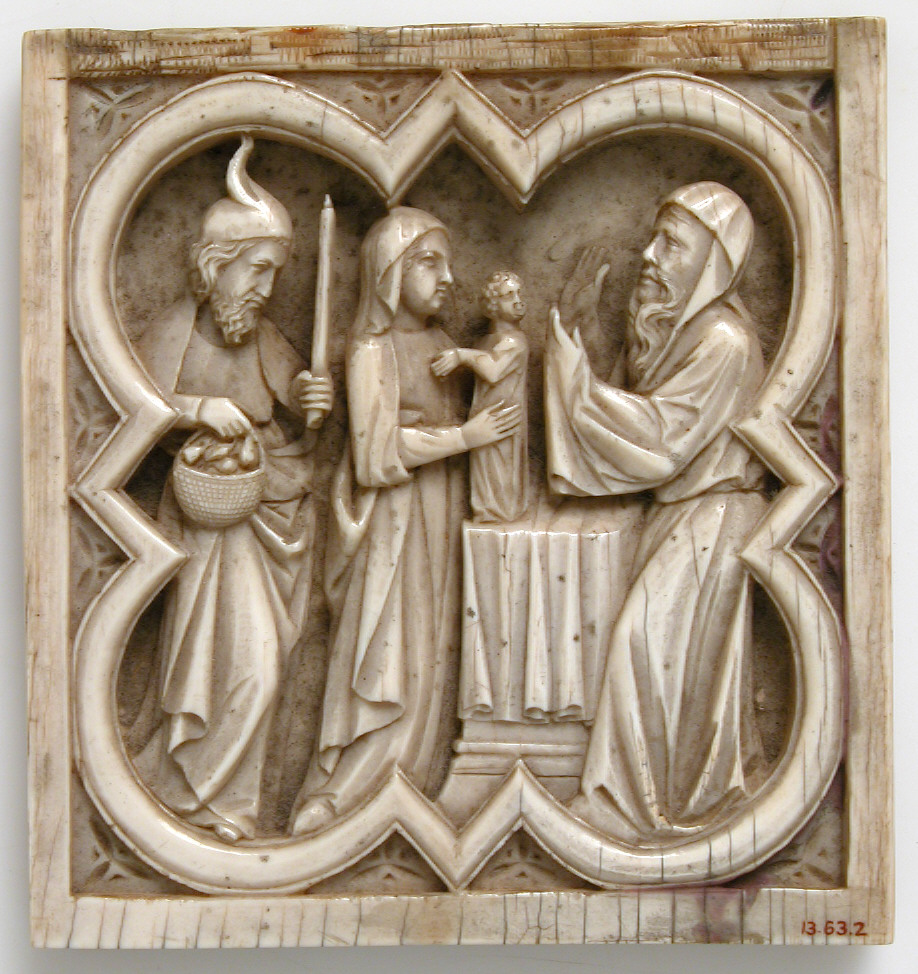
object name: panel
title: Panel with Presentation in the Temple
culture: european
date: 1801-1900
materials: ivory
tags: men,virgin mary